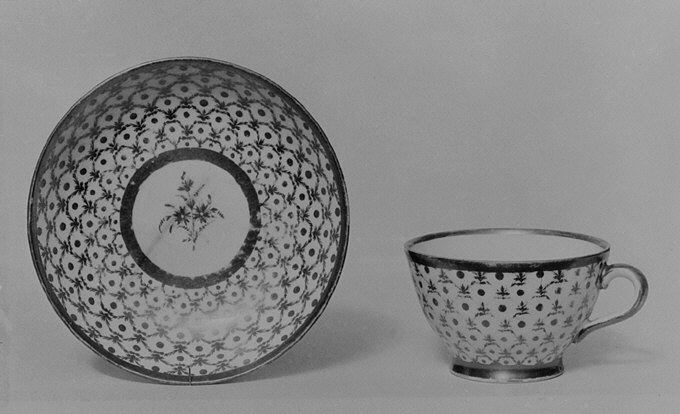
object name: cup and saucer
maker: rue thiroux: queen's factory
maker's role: factory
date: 1778-1799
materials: hard paste porcelain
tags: flowers